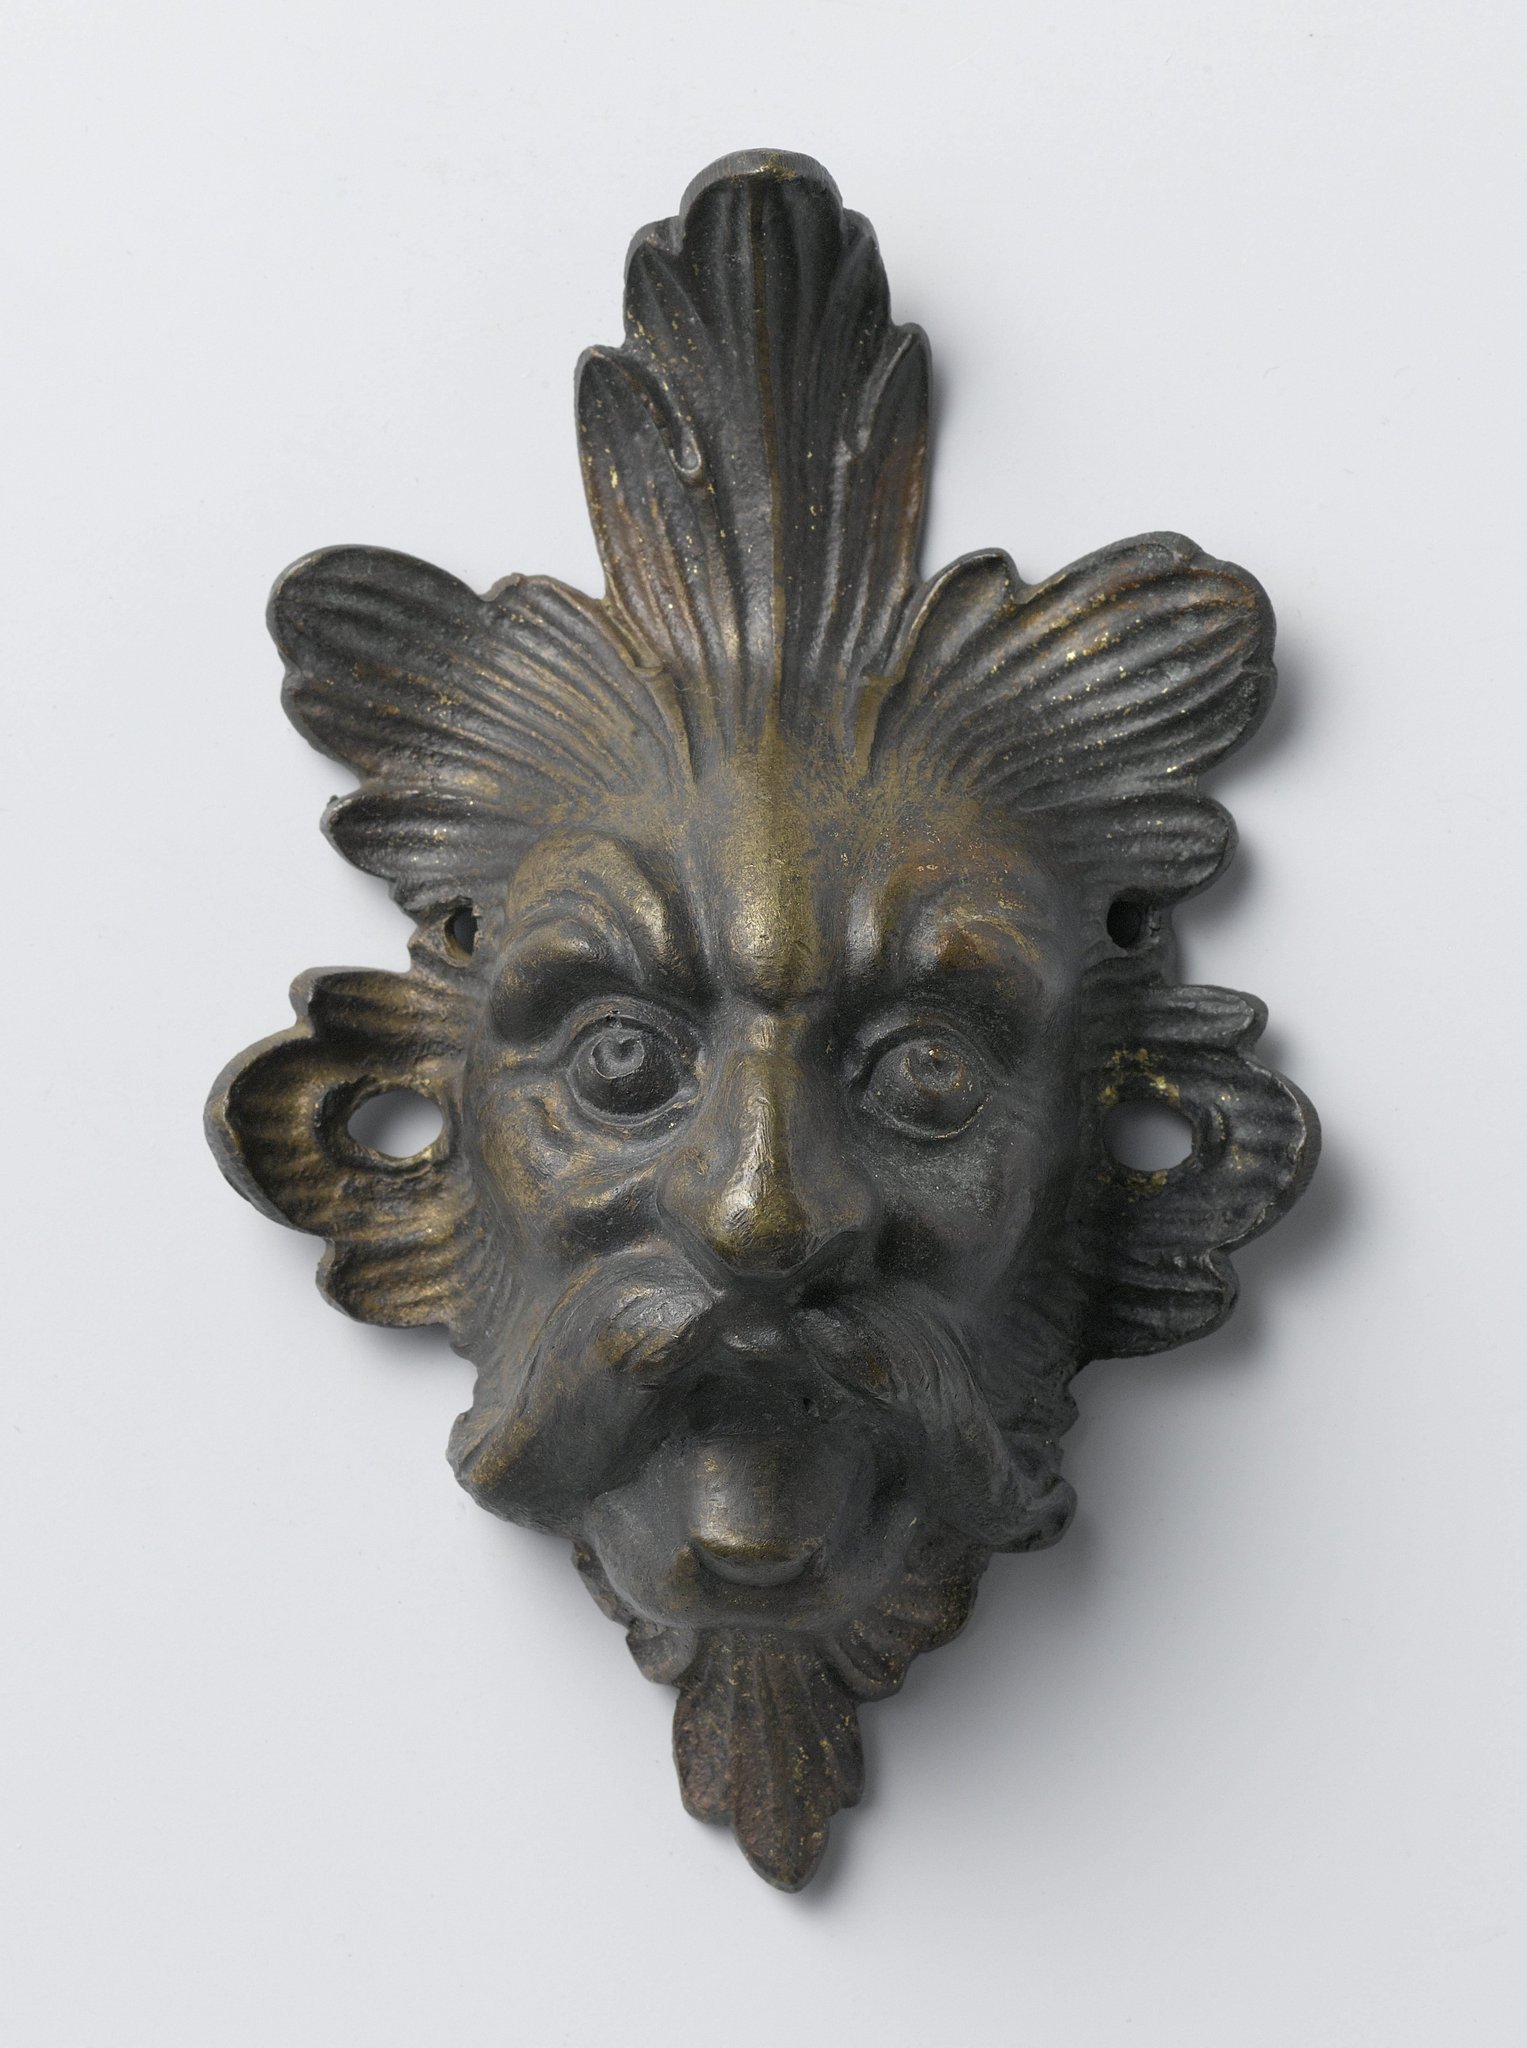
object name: sculpture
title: Mascaron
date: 1600-1699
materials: bronze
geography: italy